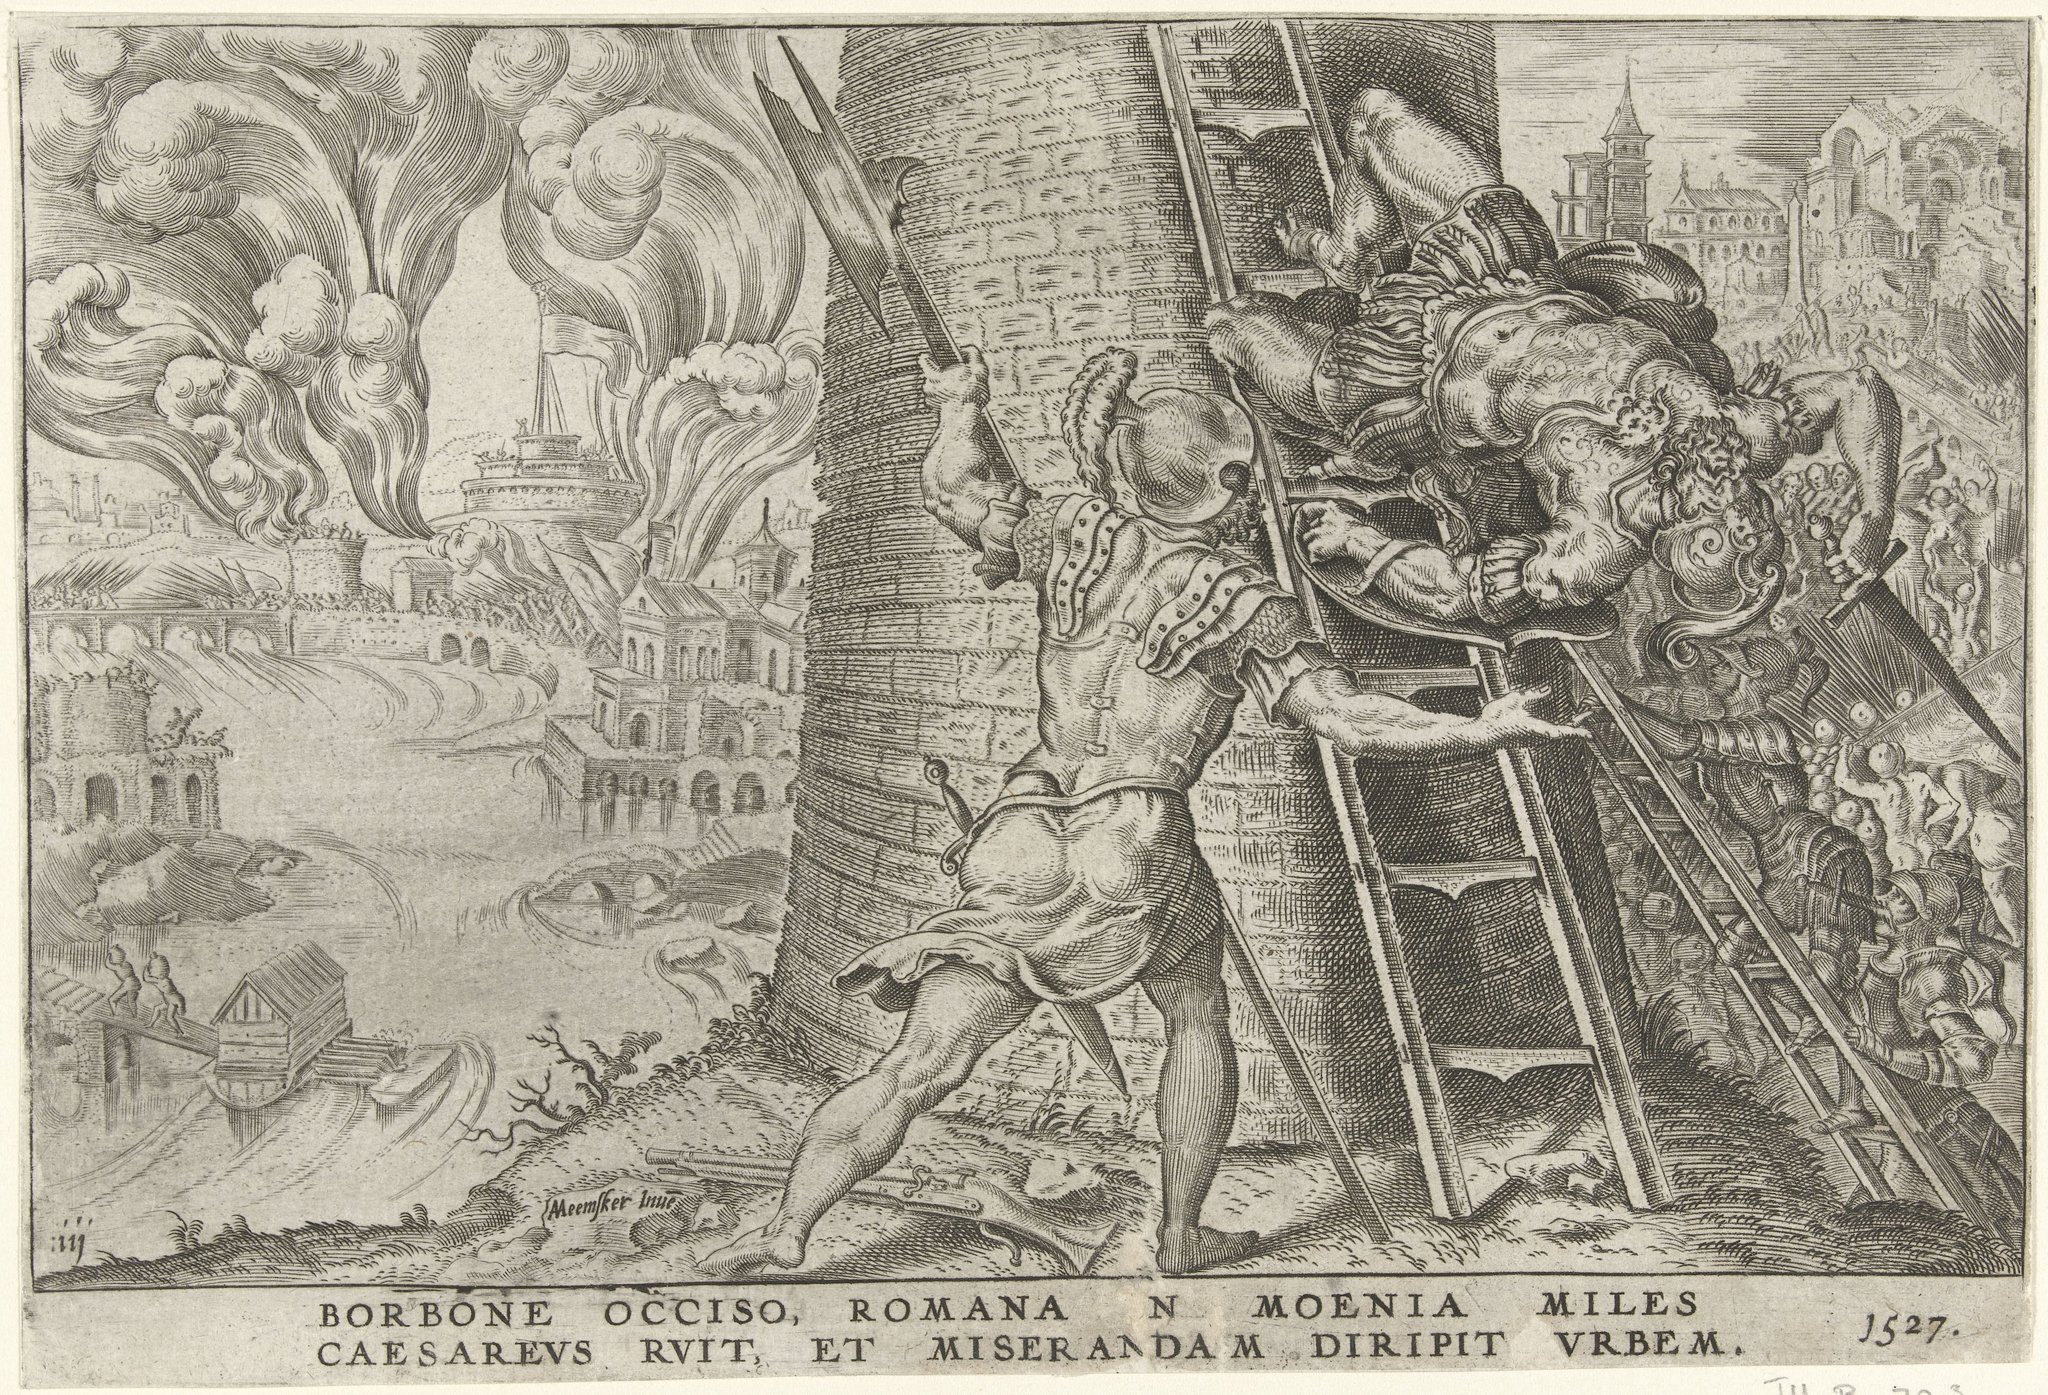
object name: print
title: Bestorming van Rome, 1527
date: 1555-1556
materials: paper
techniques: engraving, etching, letterpress printing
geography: haarlem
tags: ghent, charles v (holy roman emperor and king of spain), rome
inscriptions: collector's mark: Lugt 2228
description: De belegering van Rome (1527). Generaal Karel van Bourbon valt van een ladder nadat hij dodelijk wordt verwond door een pijl. Op de achtergrond de Tiber en de Engelenburcht. De prent heeft een Latijns onderschrift en maakt deel uit van een twaalfdelige serie over de overwinningen van Karel V.